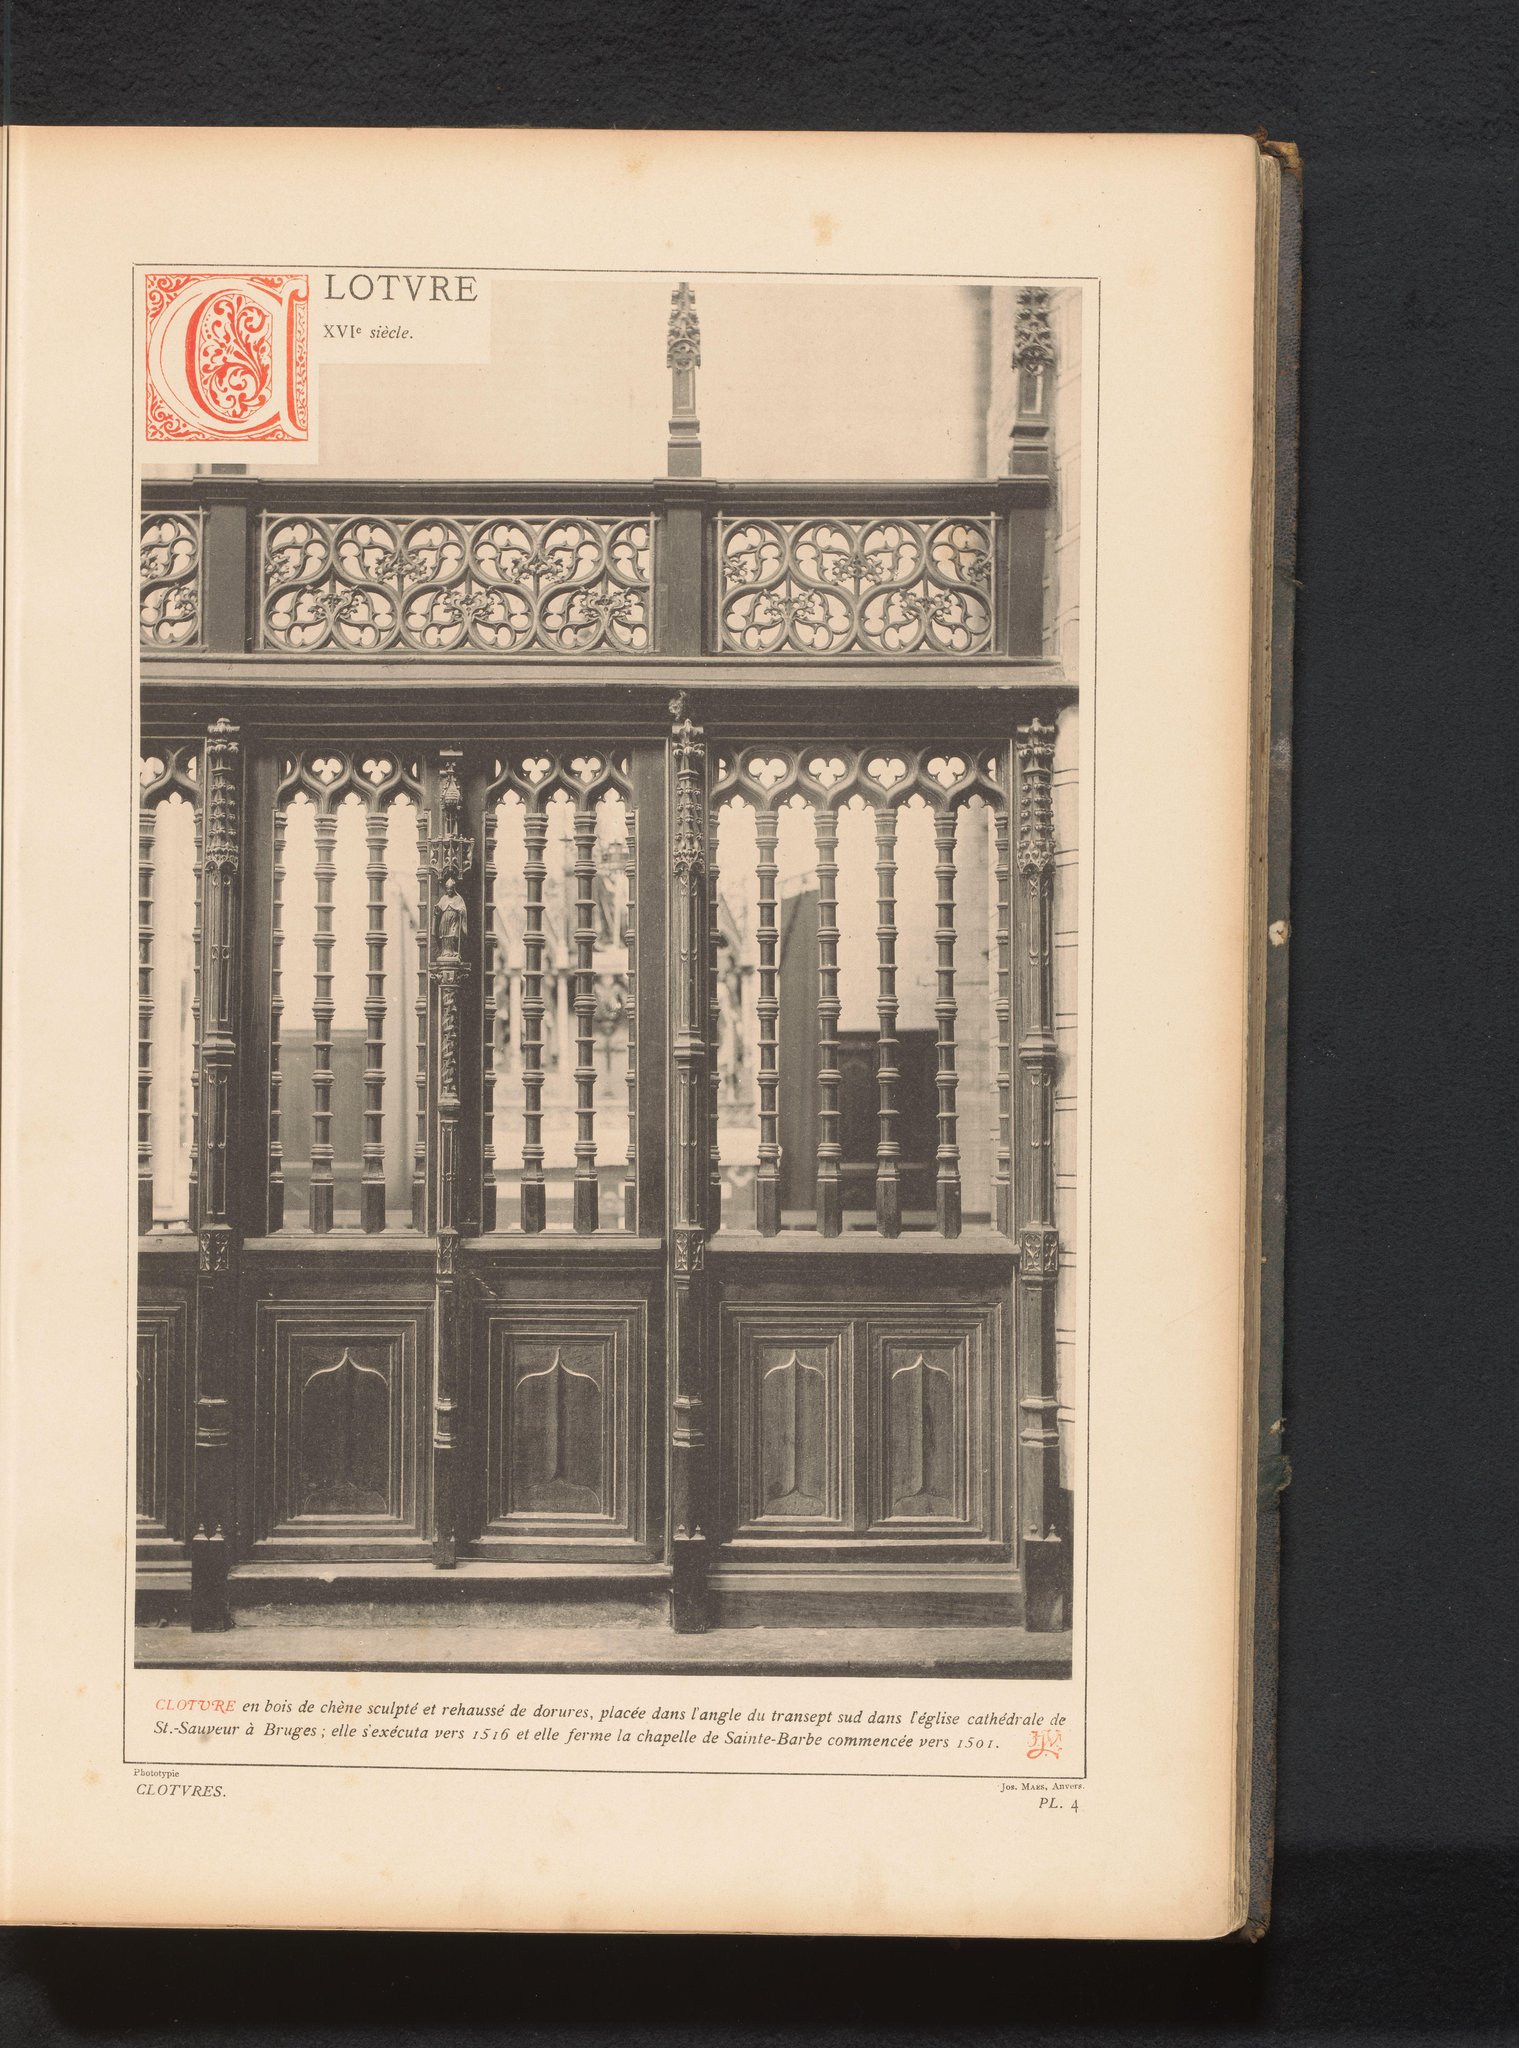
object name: photomechanical print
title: Koorhek in de zuidelijk transept van de Sint-Salvatorskathedraal in Brugge, België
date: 1882-1887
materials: paper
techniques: photograph, photolithography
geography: sint-salvatorskathedraal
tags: parts of church interior: transept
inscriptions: monogram: ‘JJvY’, inscription: ‘CLOTURES. - PL. 4’, inscription: ‘CLOTURE en bois (...)’